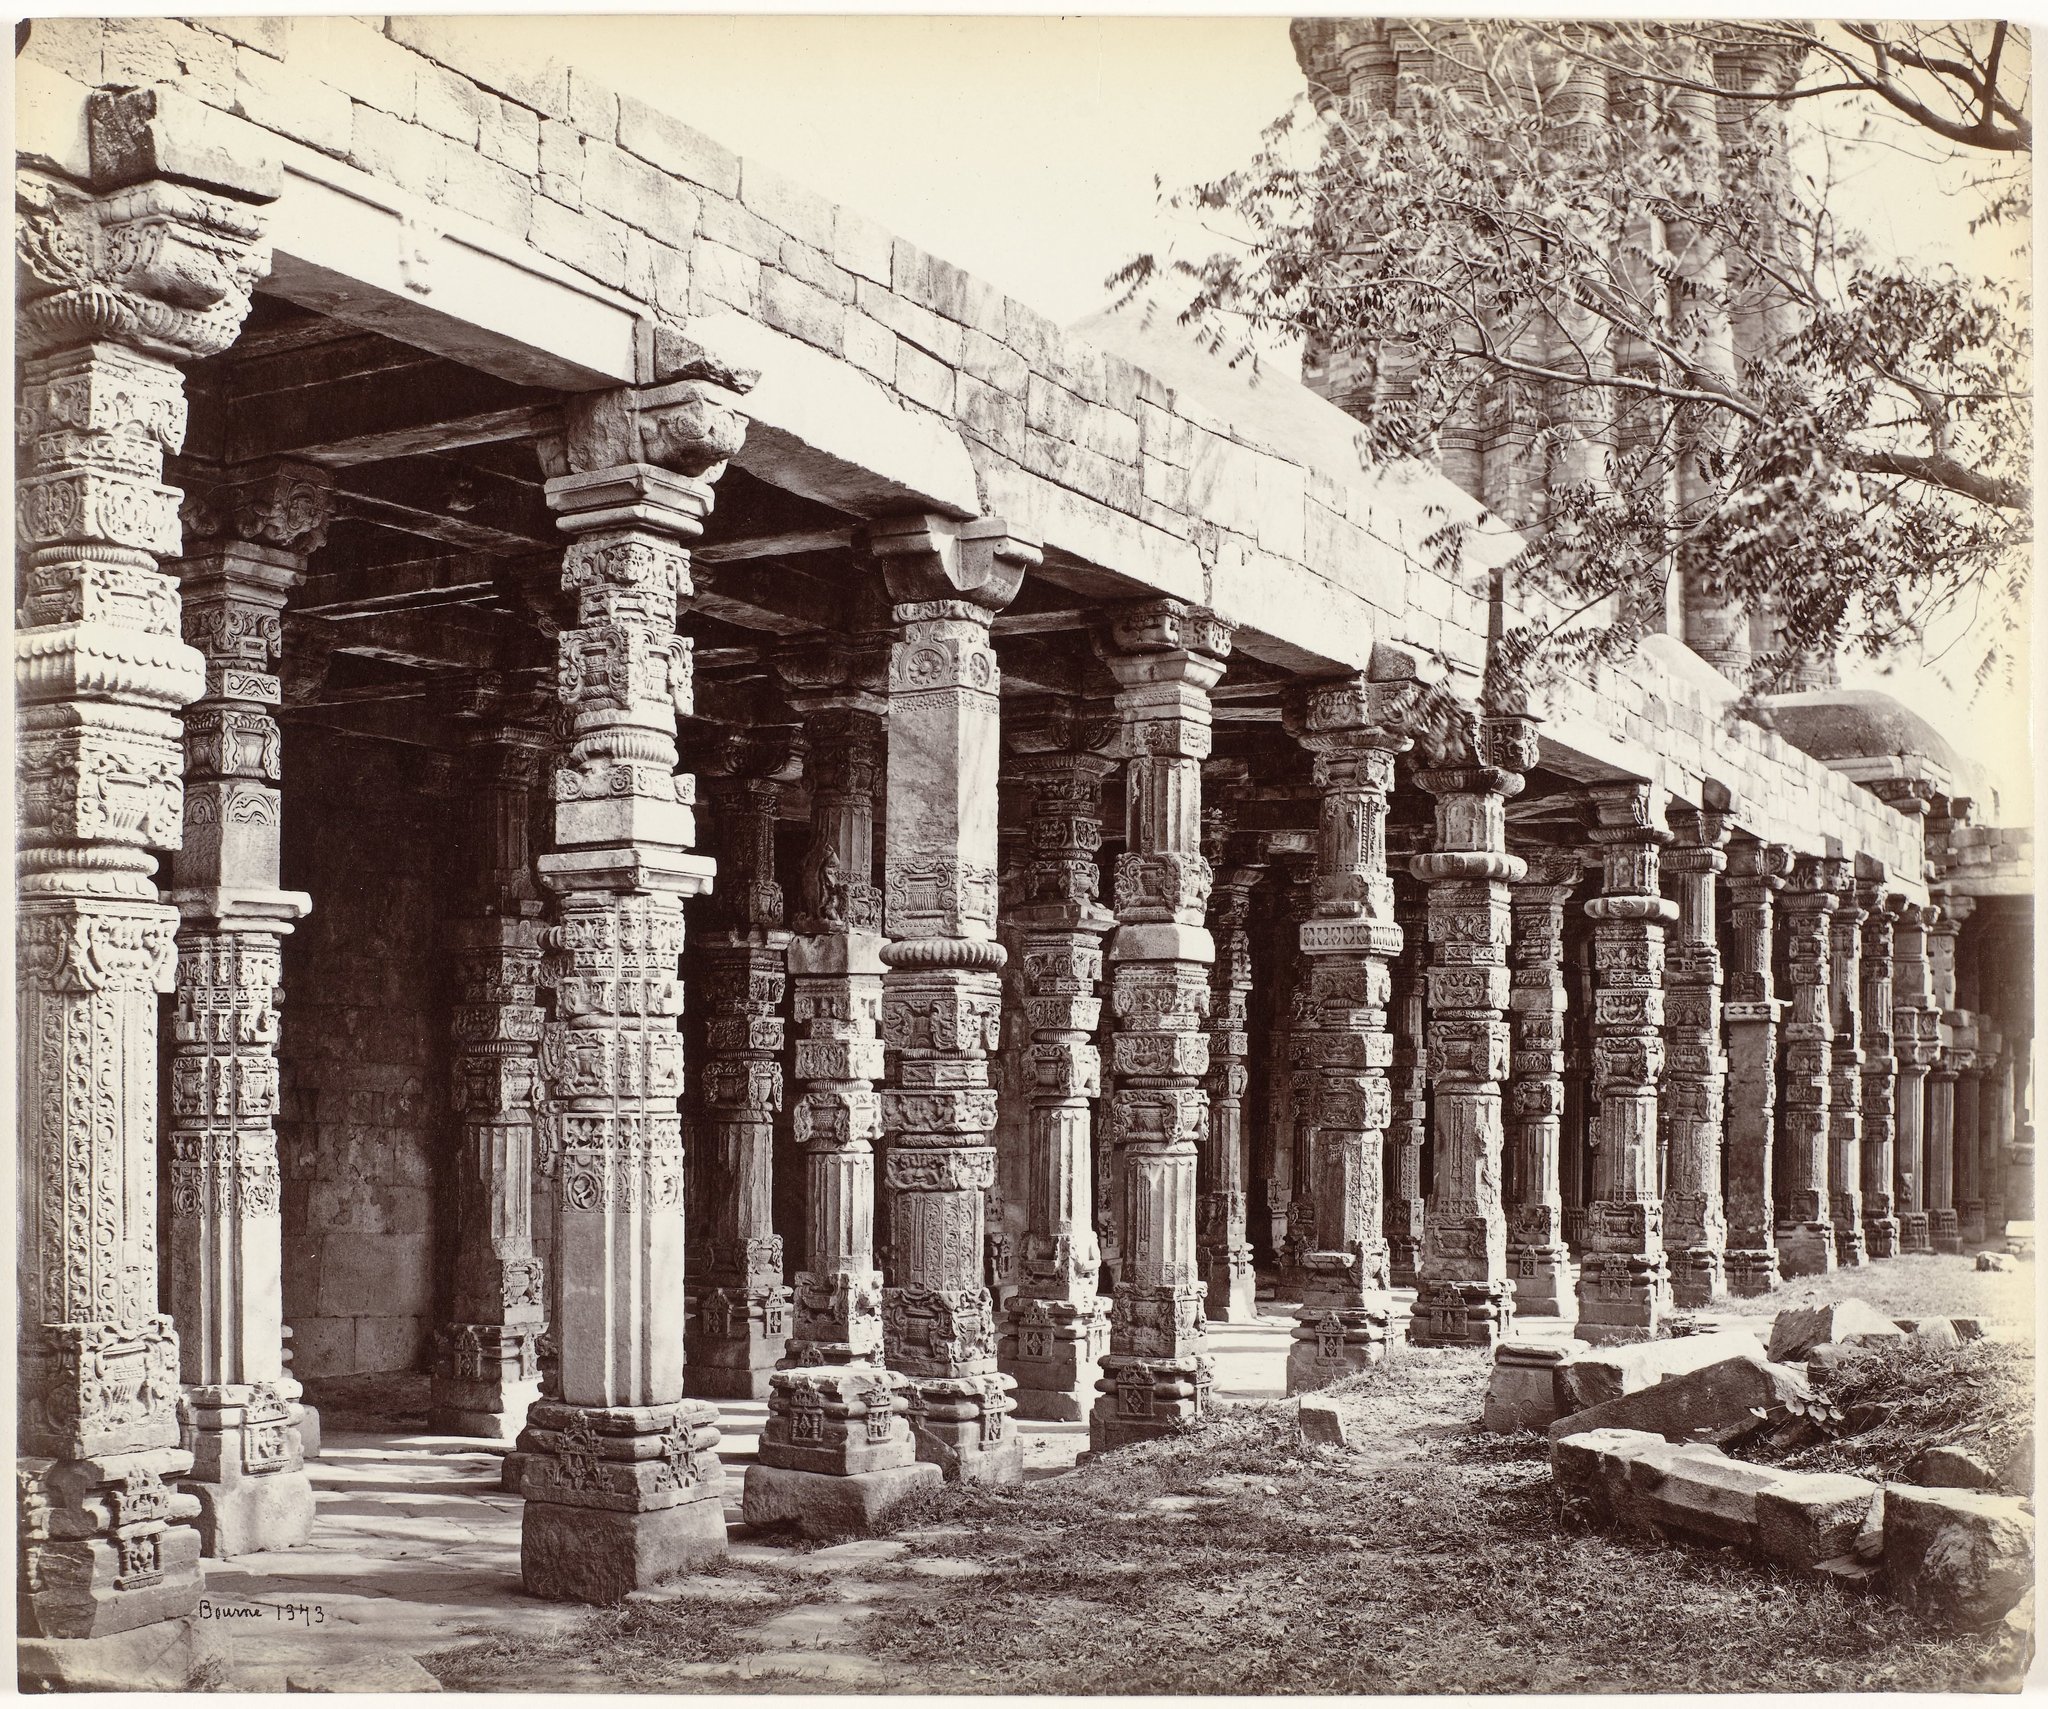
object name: photograph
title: Ornamental colonnade at the base of the Qutb Minar in Delhi, India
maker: samuel bourne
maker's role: fotograaf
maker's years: 1834-1912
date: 1863-1865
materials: paper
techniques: albumen print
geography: delhi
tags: temple, shrine ~ hinduism, buddhism, jainism, colonnade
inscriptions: name: ‘Bourne’, inscription: ‘1373 Delhi/ Colonnade of Hindu Pillars/ at the Kutub East side’, number: ‘1373’